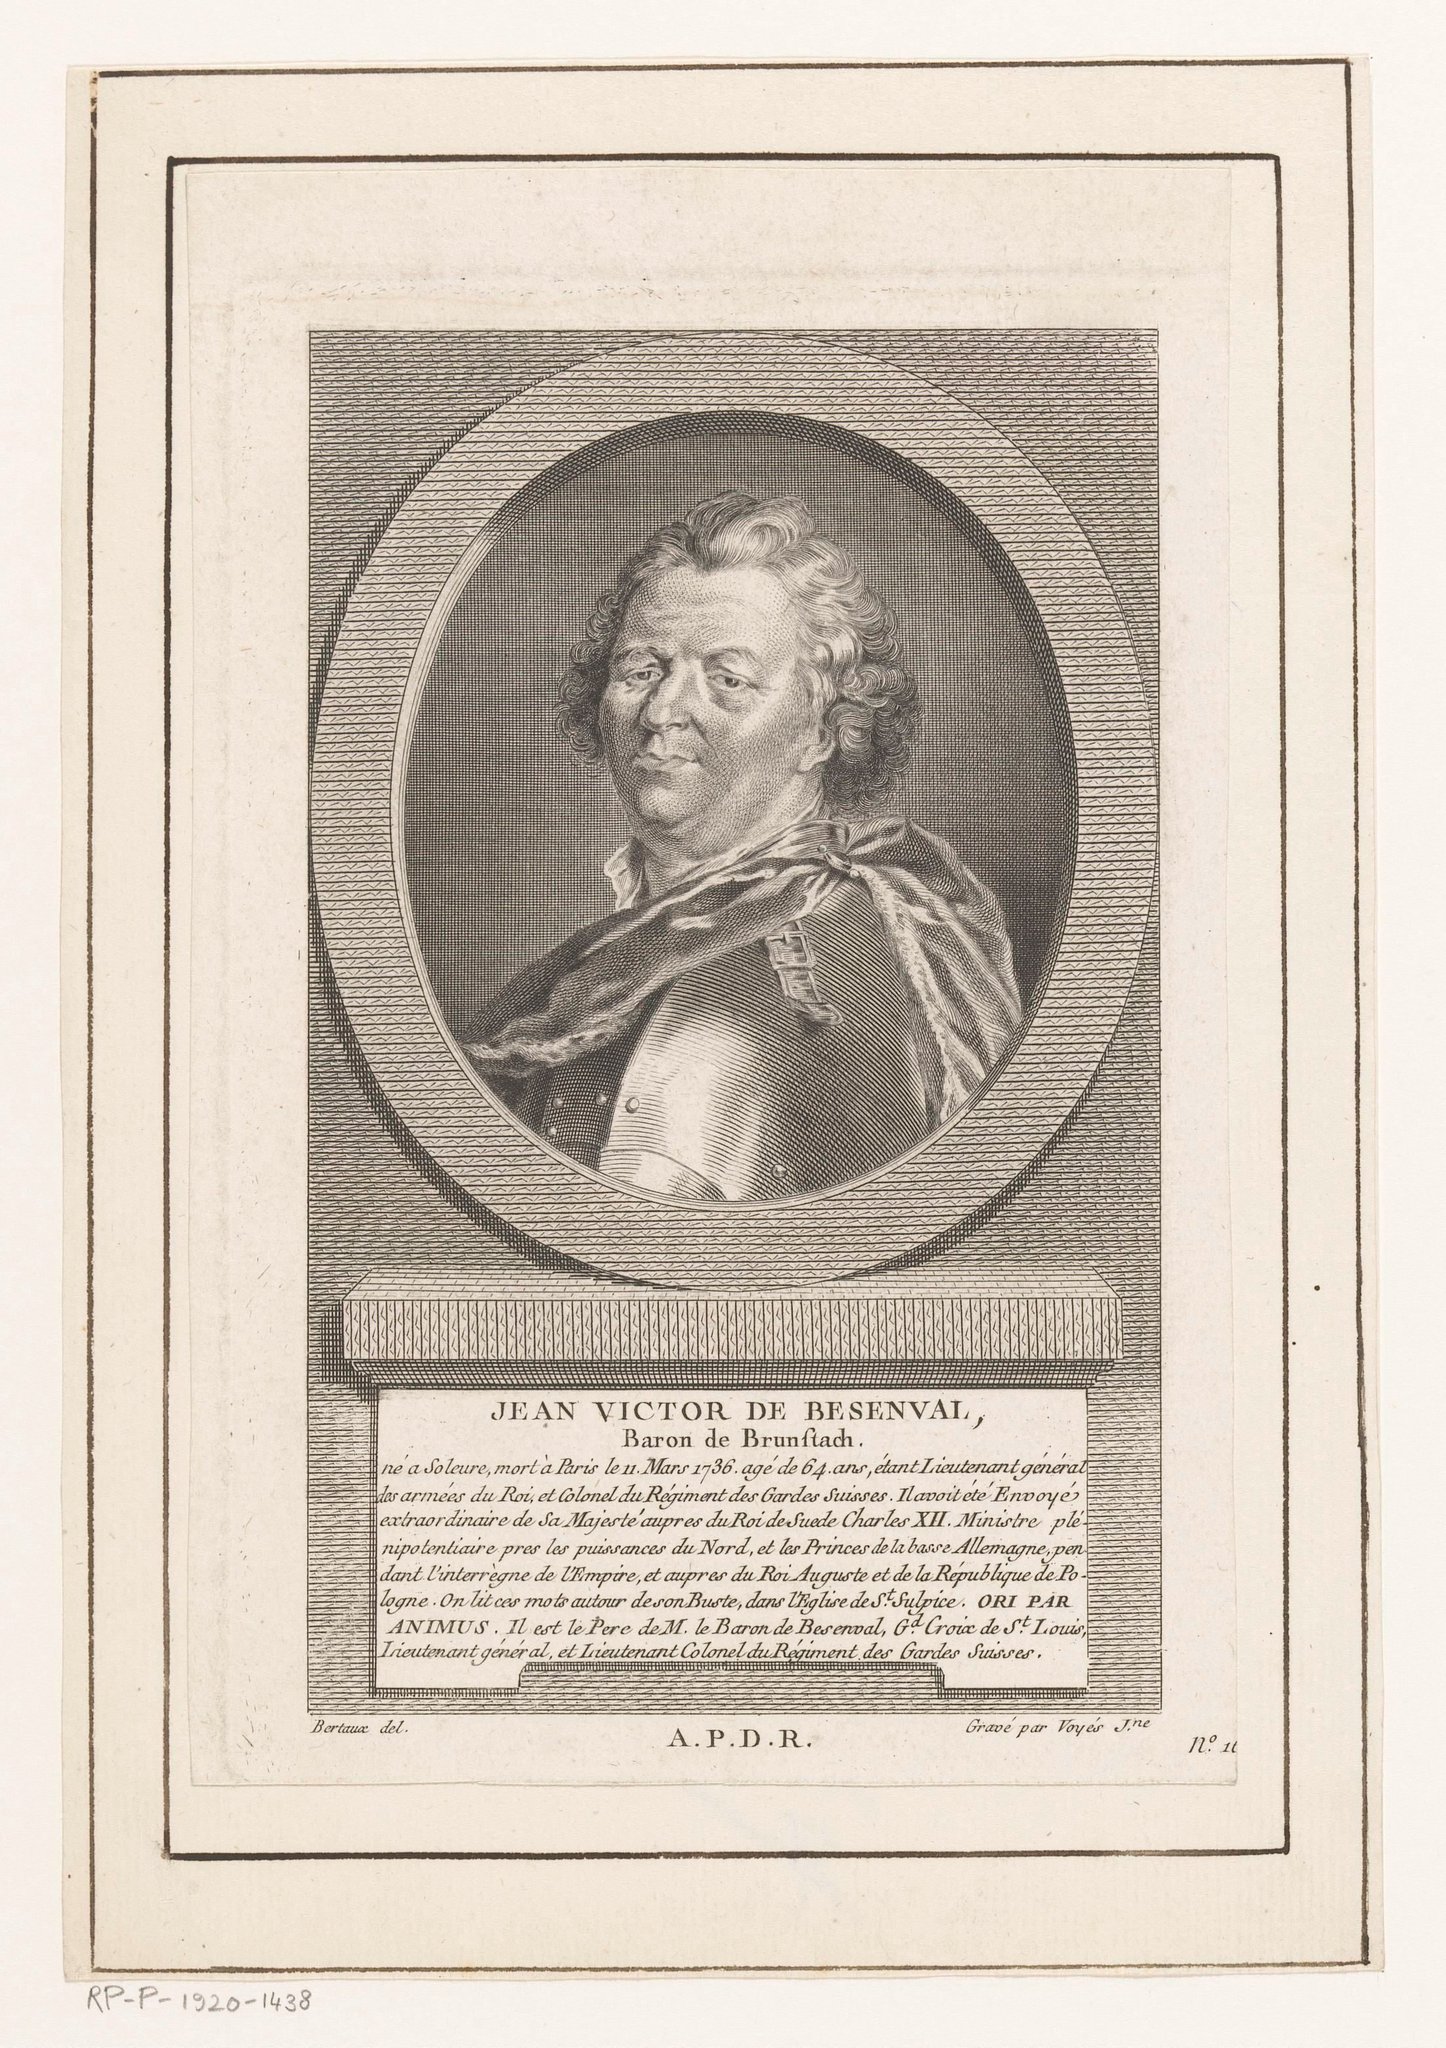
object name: print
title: Portret van Jean-Victor de Besenval de Brünstatt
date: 1756-1805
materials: paper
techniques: engraving, etching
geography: france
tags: germany, historical persons, officer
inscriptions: collector's mark: Lugt 2228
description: Buste van Jean-Victor de Besenval de Brünstatt in een ovaal met onderaan een plaquette met biografische informatie. Genummerd rechtsonder: No. 16.